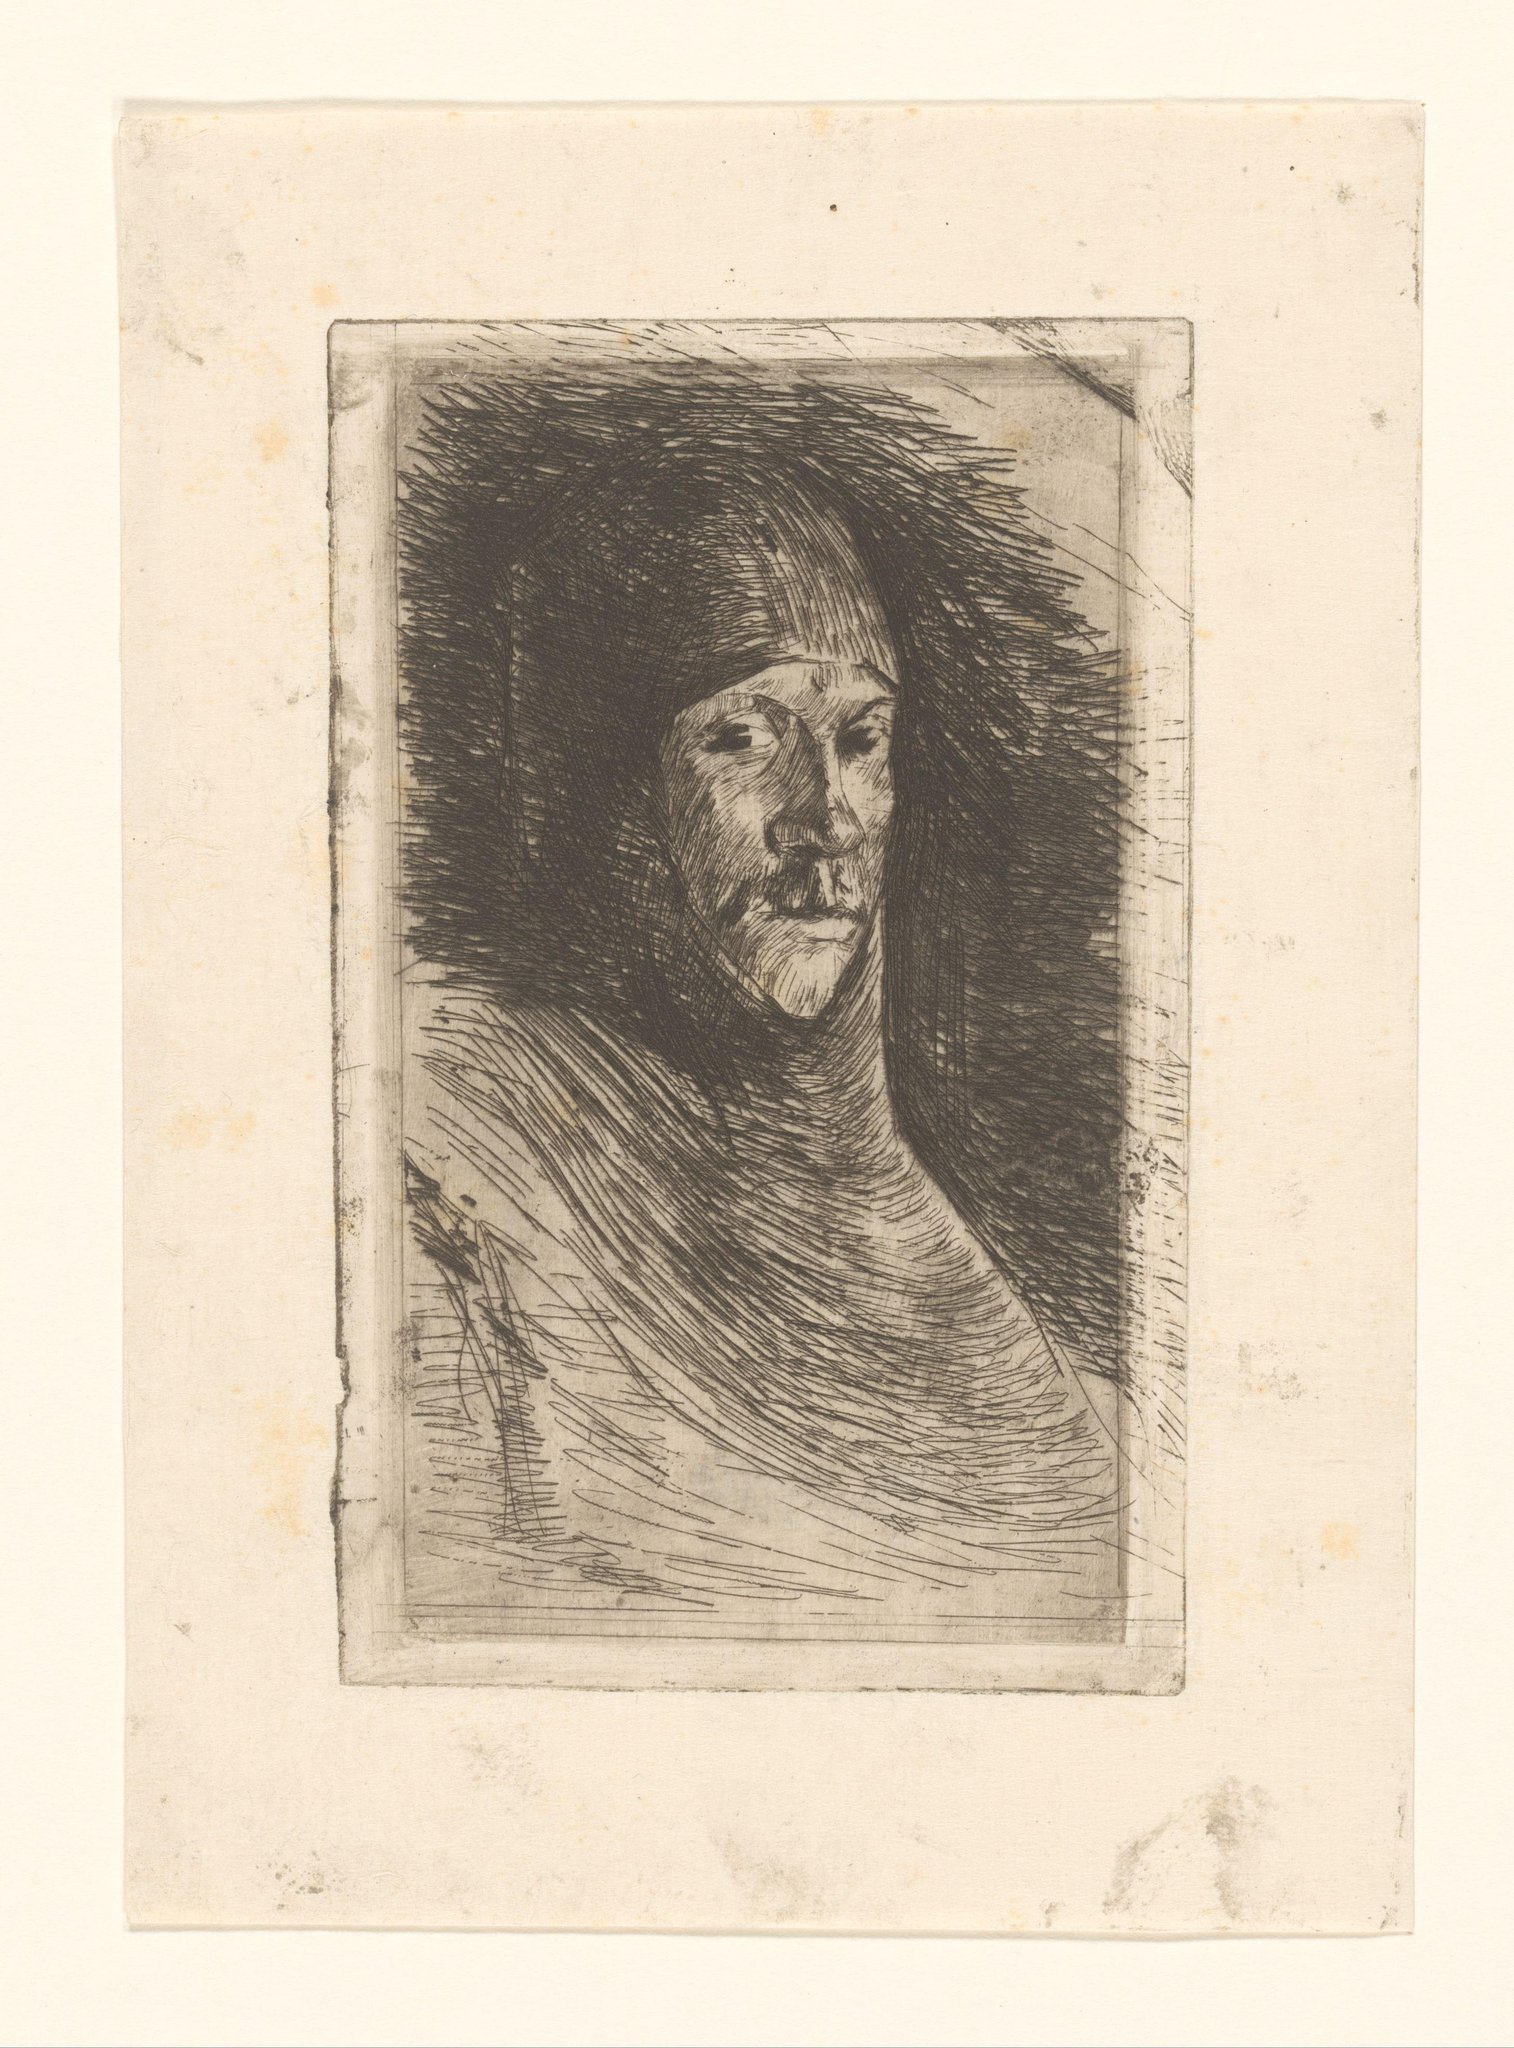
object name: print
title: Man met maliënkolder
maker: willem de zwart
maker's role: draughtsman, painter, print maker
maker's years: 1862-1931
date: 1884-1885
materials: paper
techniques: etching, intaglio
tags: historical persons, knight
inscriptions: collector's mark: Lugt 2233